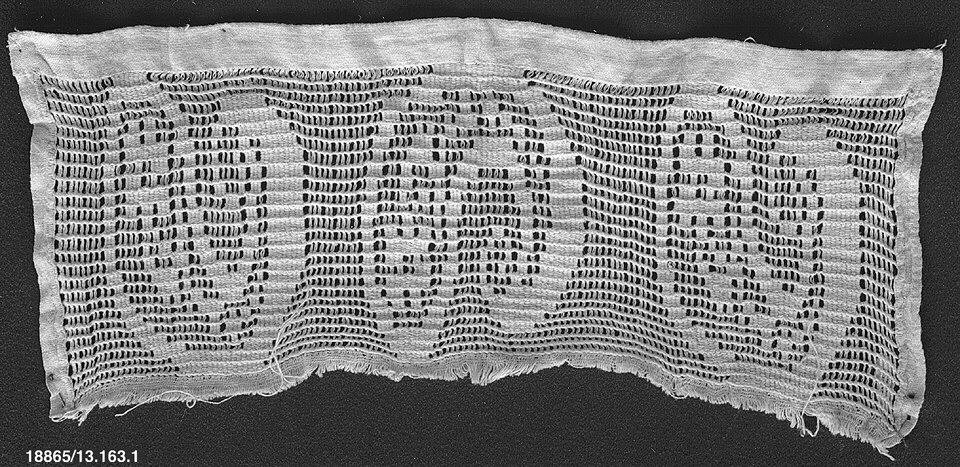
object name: band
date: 1601-1800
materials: linen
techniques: embroidery